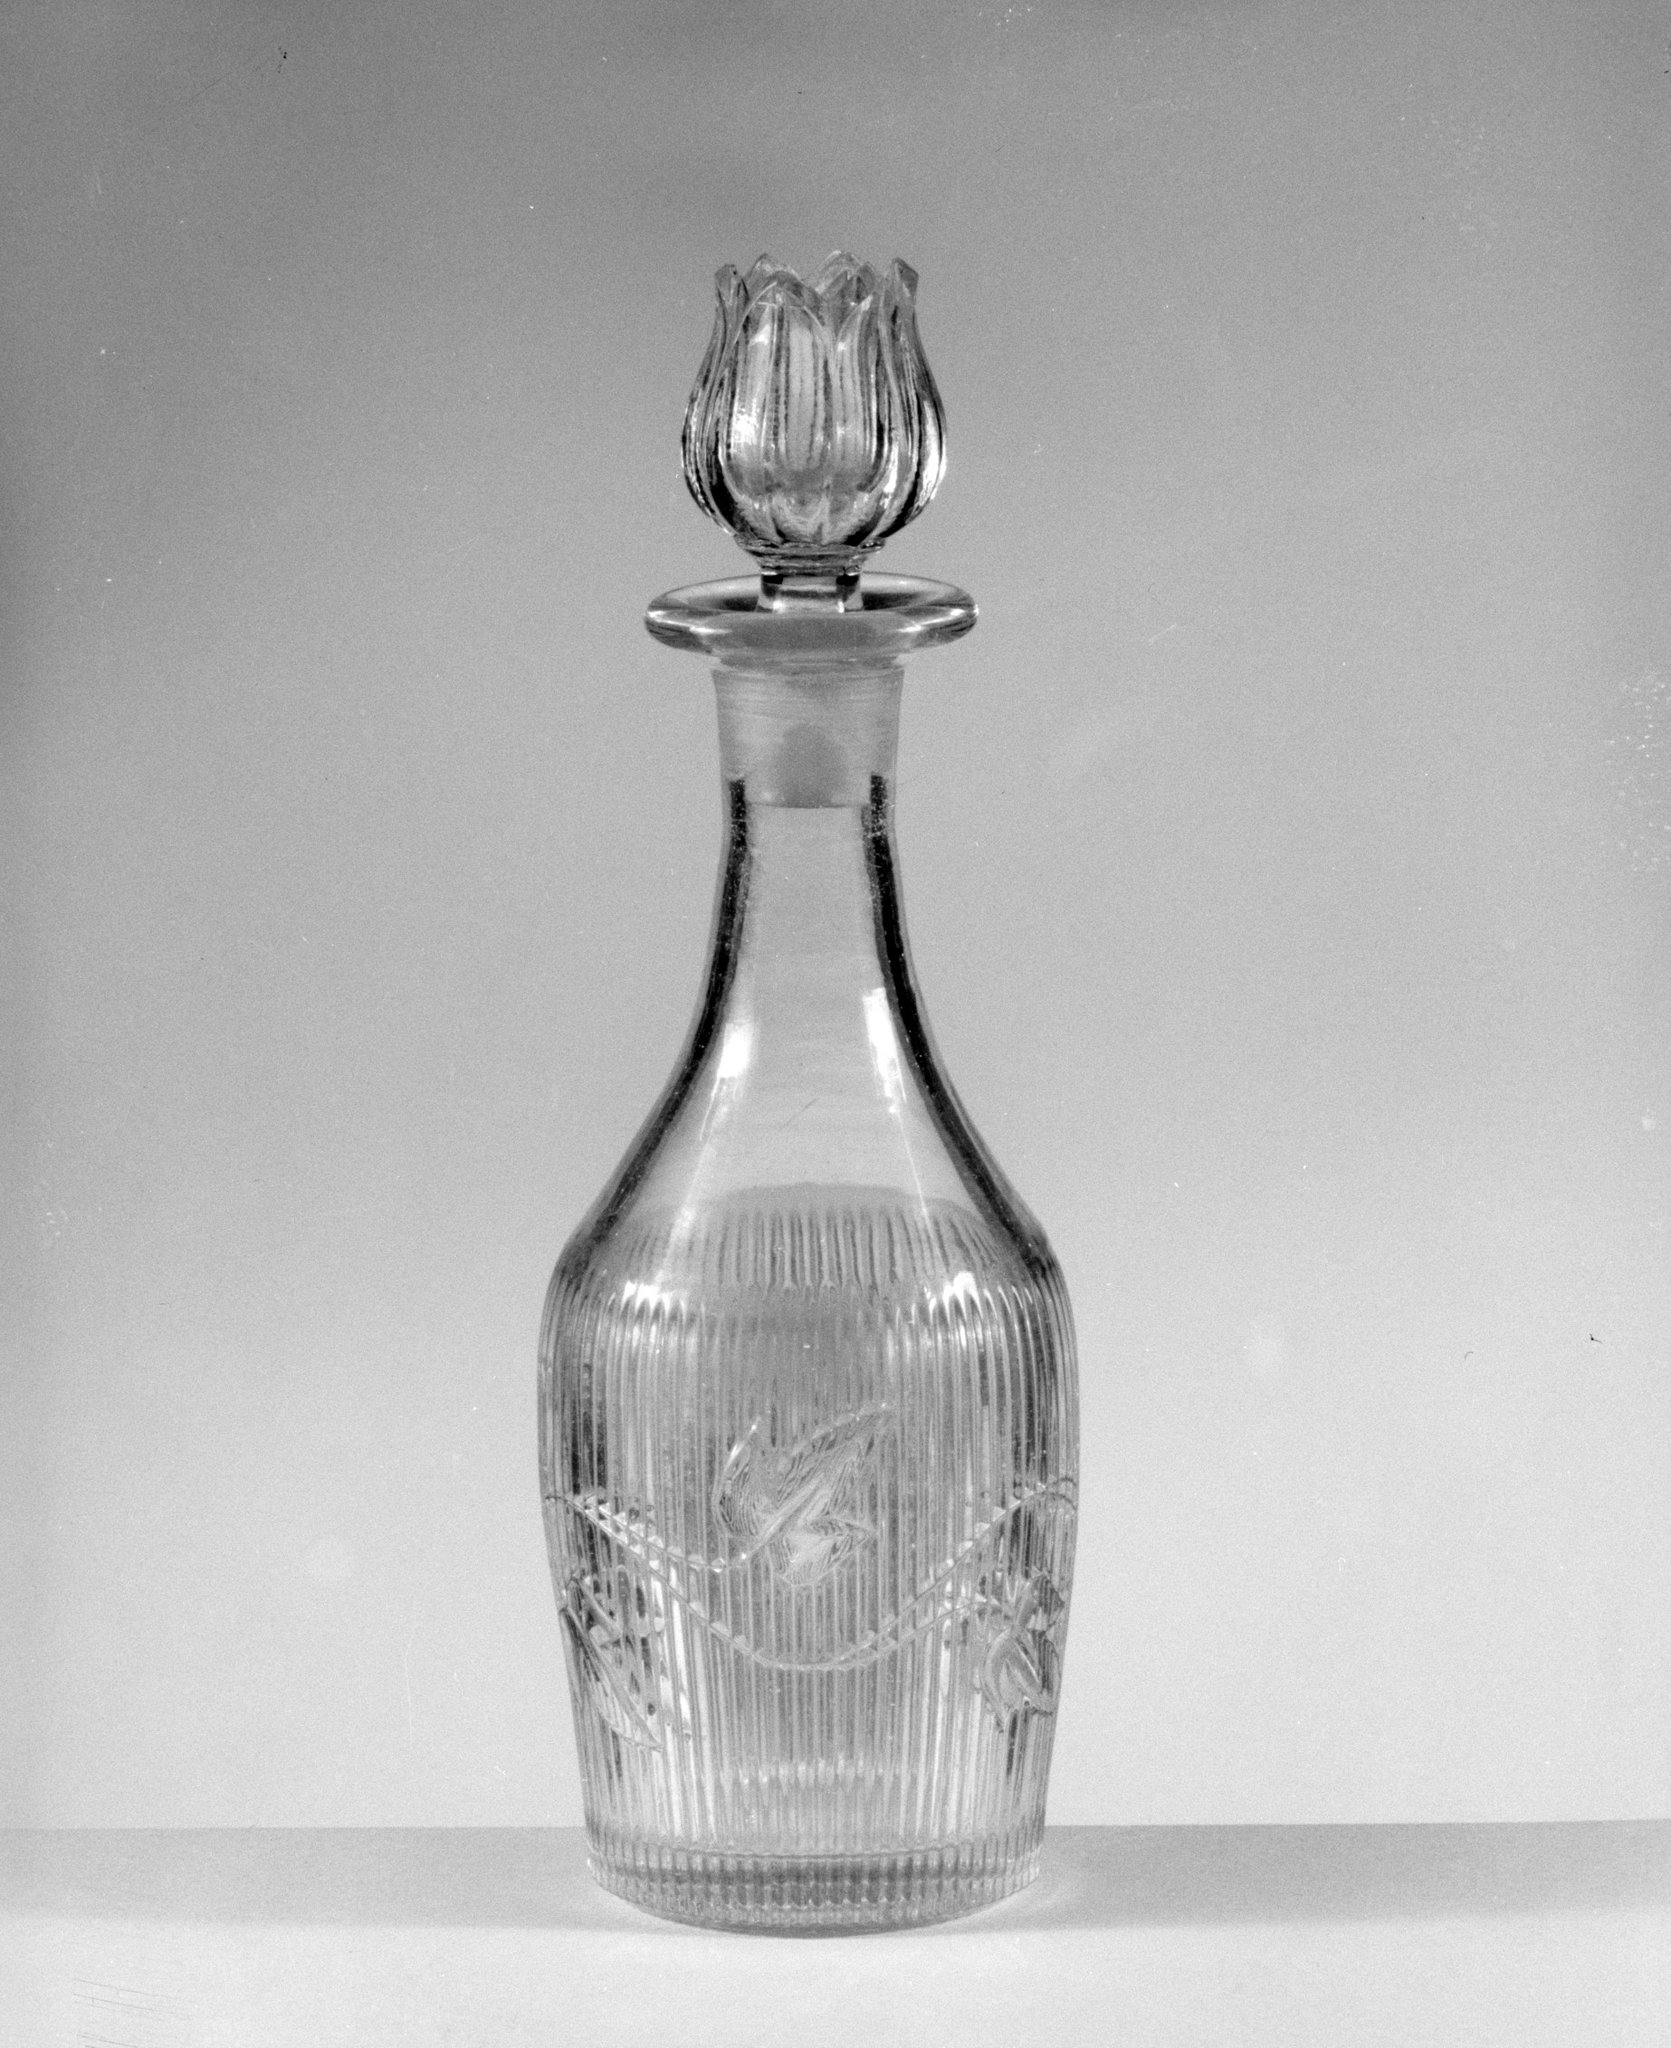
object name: bitter bottle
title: Bitters Bottle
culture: american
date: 1860-1870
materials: glass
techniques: pressed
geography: united states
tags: flowers